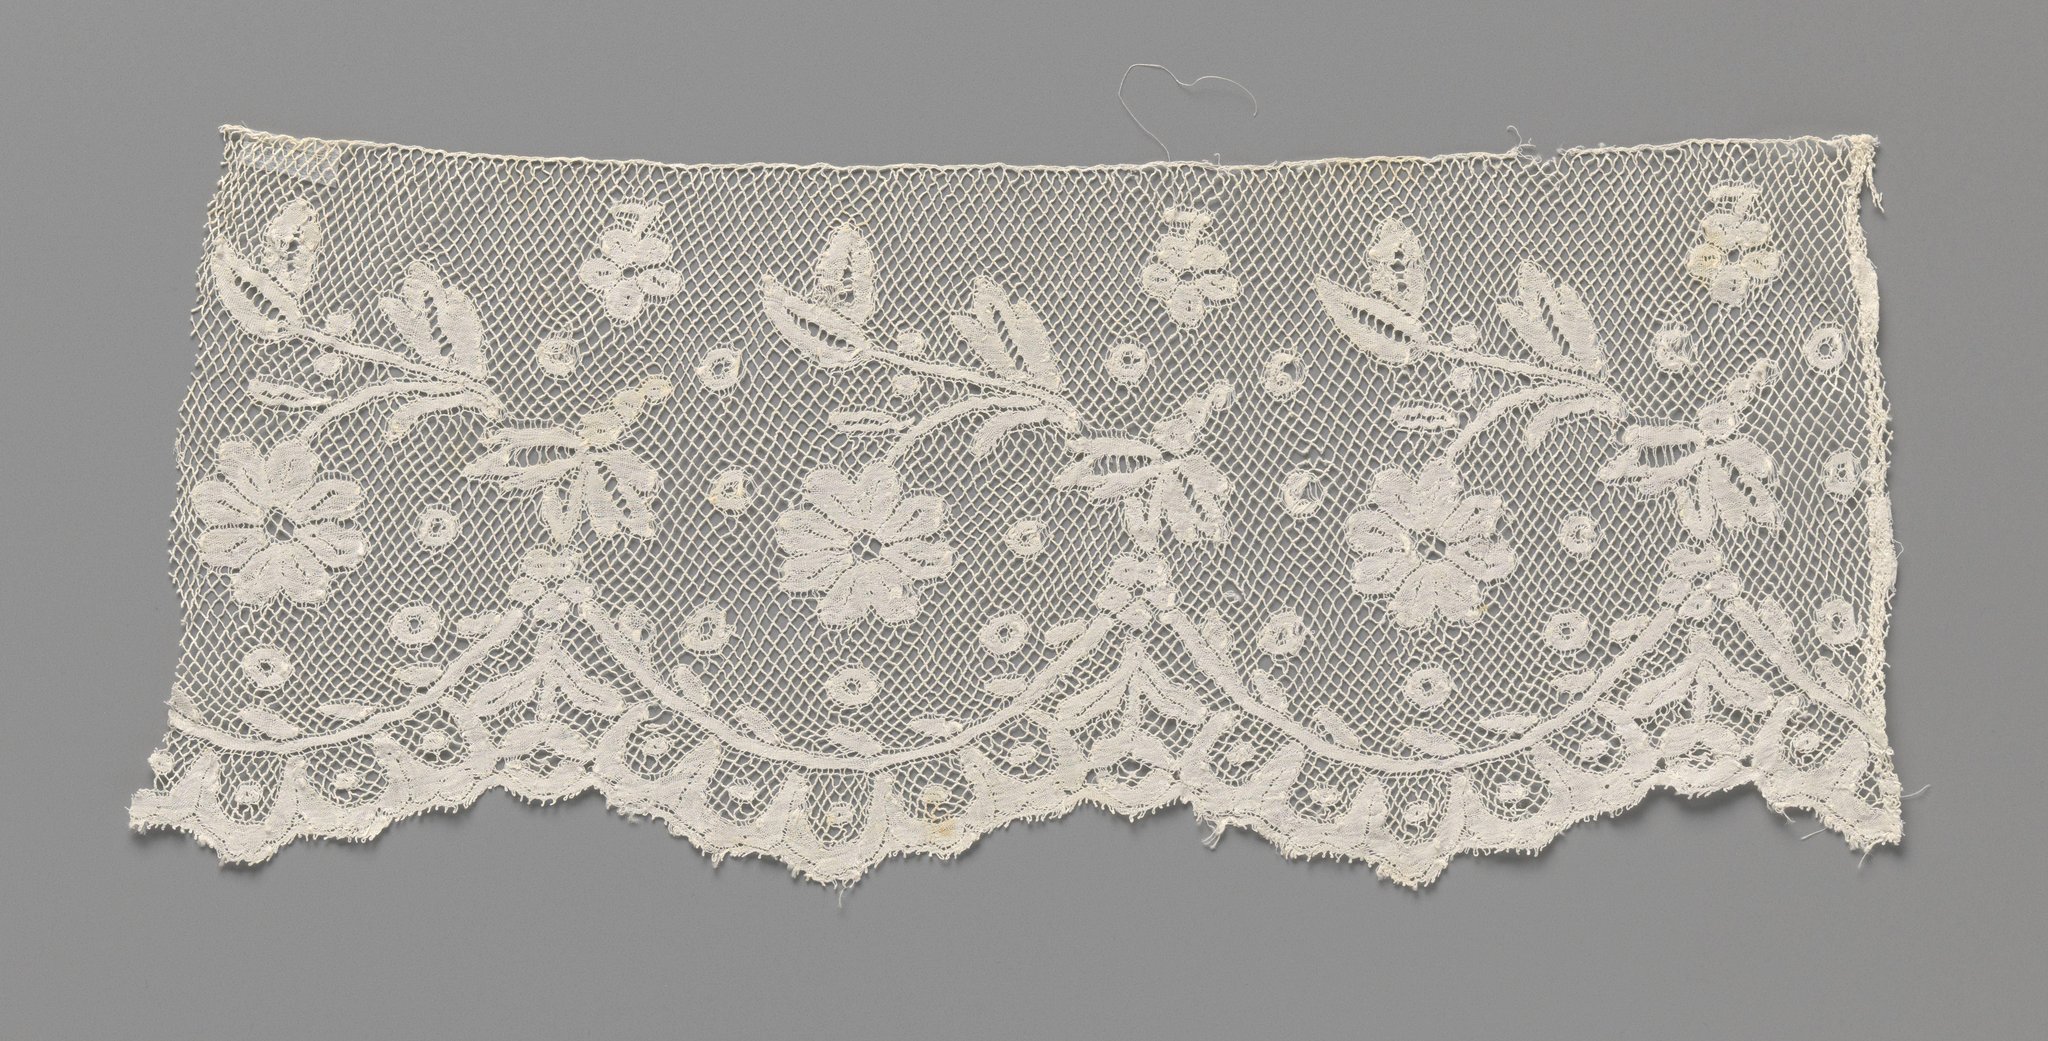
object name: strip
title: Strook kloskant met gegodroneerde schulpen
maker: Anonymous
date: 1875-1899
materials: linen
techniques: lace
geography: sluis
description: Strook naturelkleurige kloskant: Valenciennes-kant. Patroon met gegodronneerde halfcirkelvormige schulpen, waarboven een hangende margriet tussen 'pailletten'.